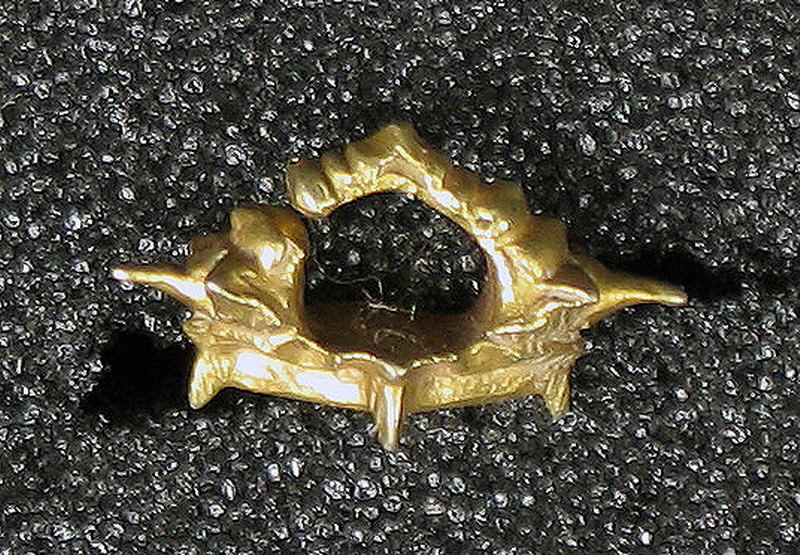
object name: earring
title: Cast Earring with Granulation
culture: indonesian, central java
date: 701-1200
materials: gold